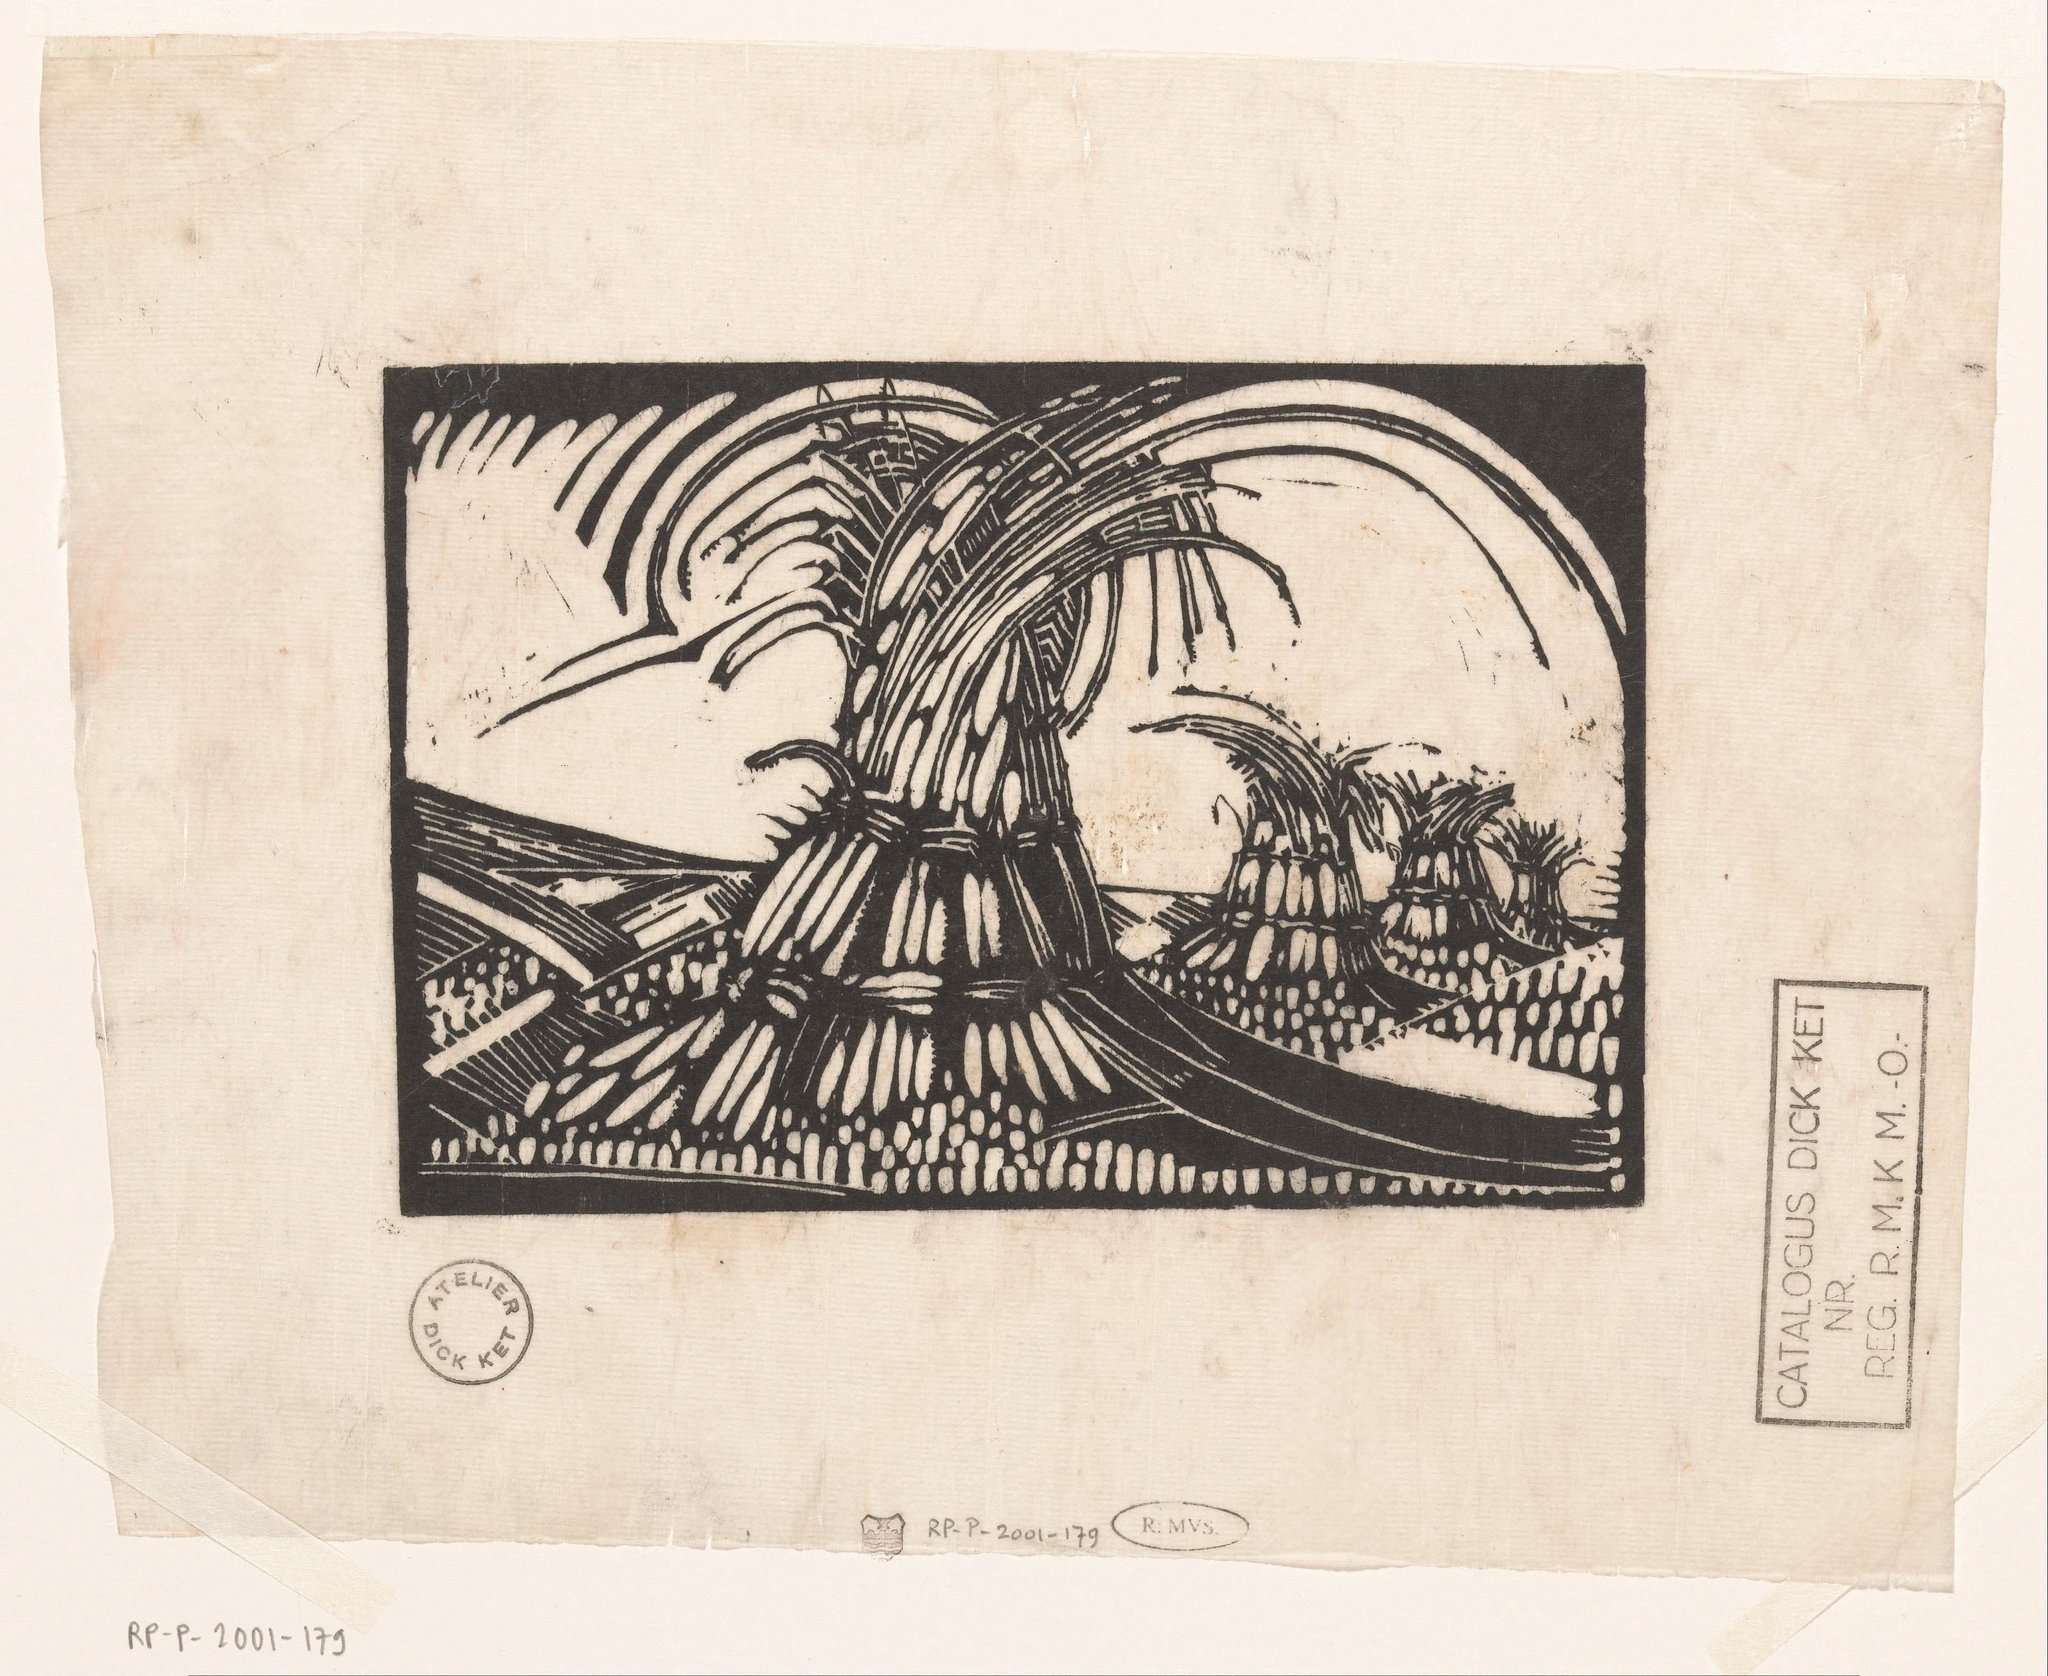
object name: print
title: Korenschoven te Ede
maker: dick ket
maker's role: draughtsman, print maker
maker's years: 1902-1940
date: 1927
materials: paper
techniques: linocut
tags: sheaf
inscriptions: workshop stamp: ‘ATELIER DICK KET’, collector's mark: Lugt 2228, collector's mark: Lugt 2760, stamp: ‘CATALOGUS DICK KET / NR. / REG. R. M. K M. -O.-’